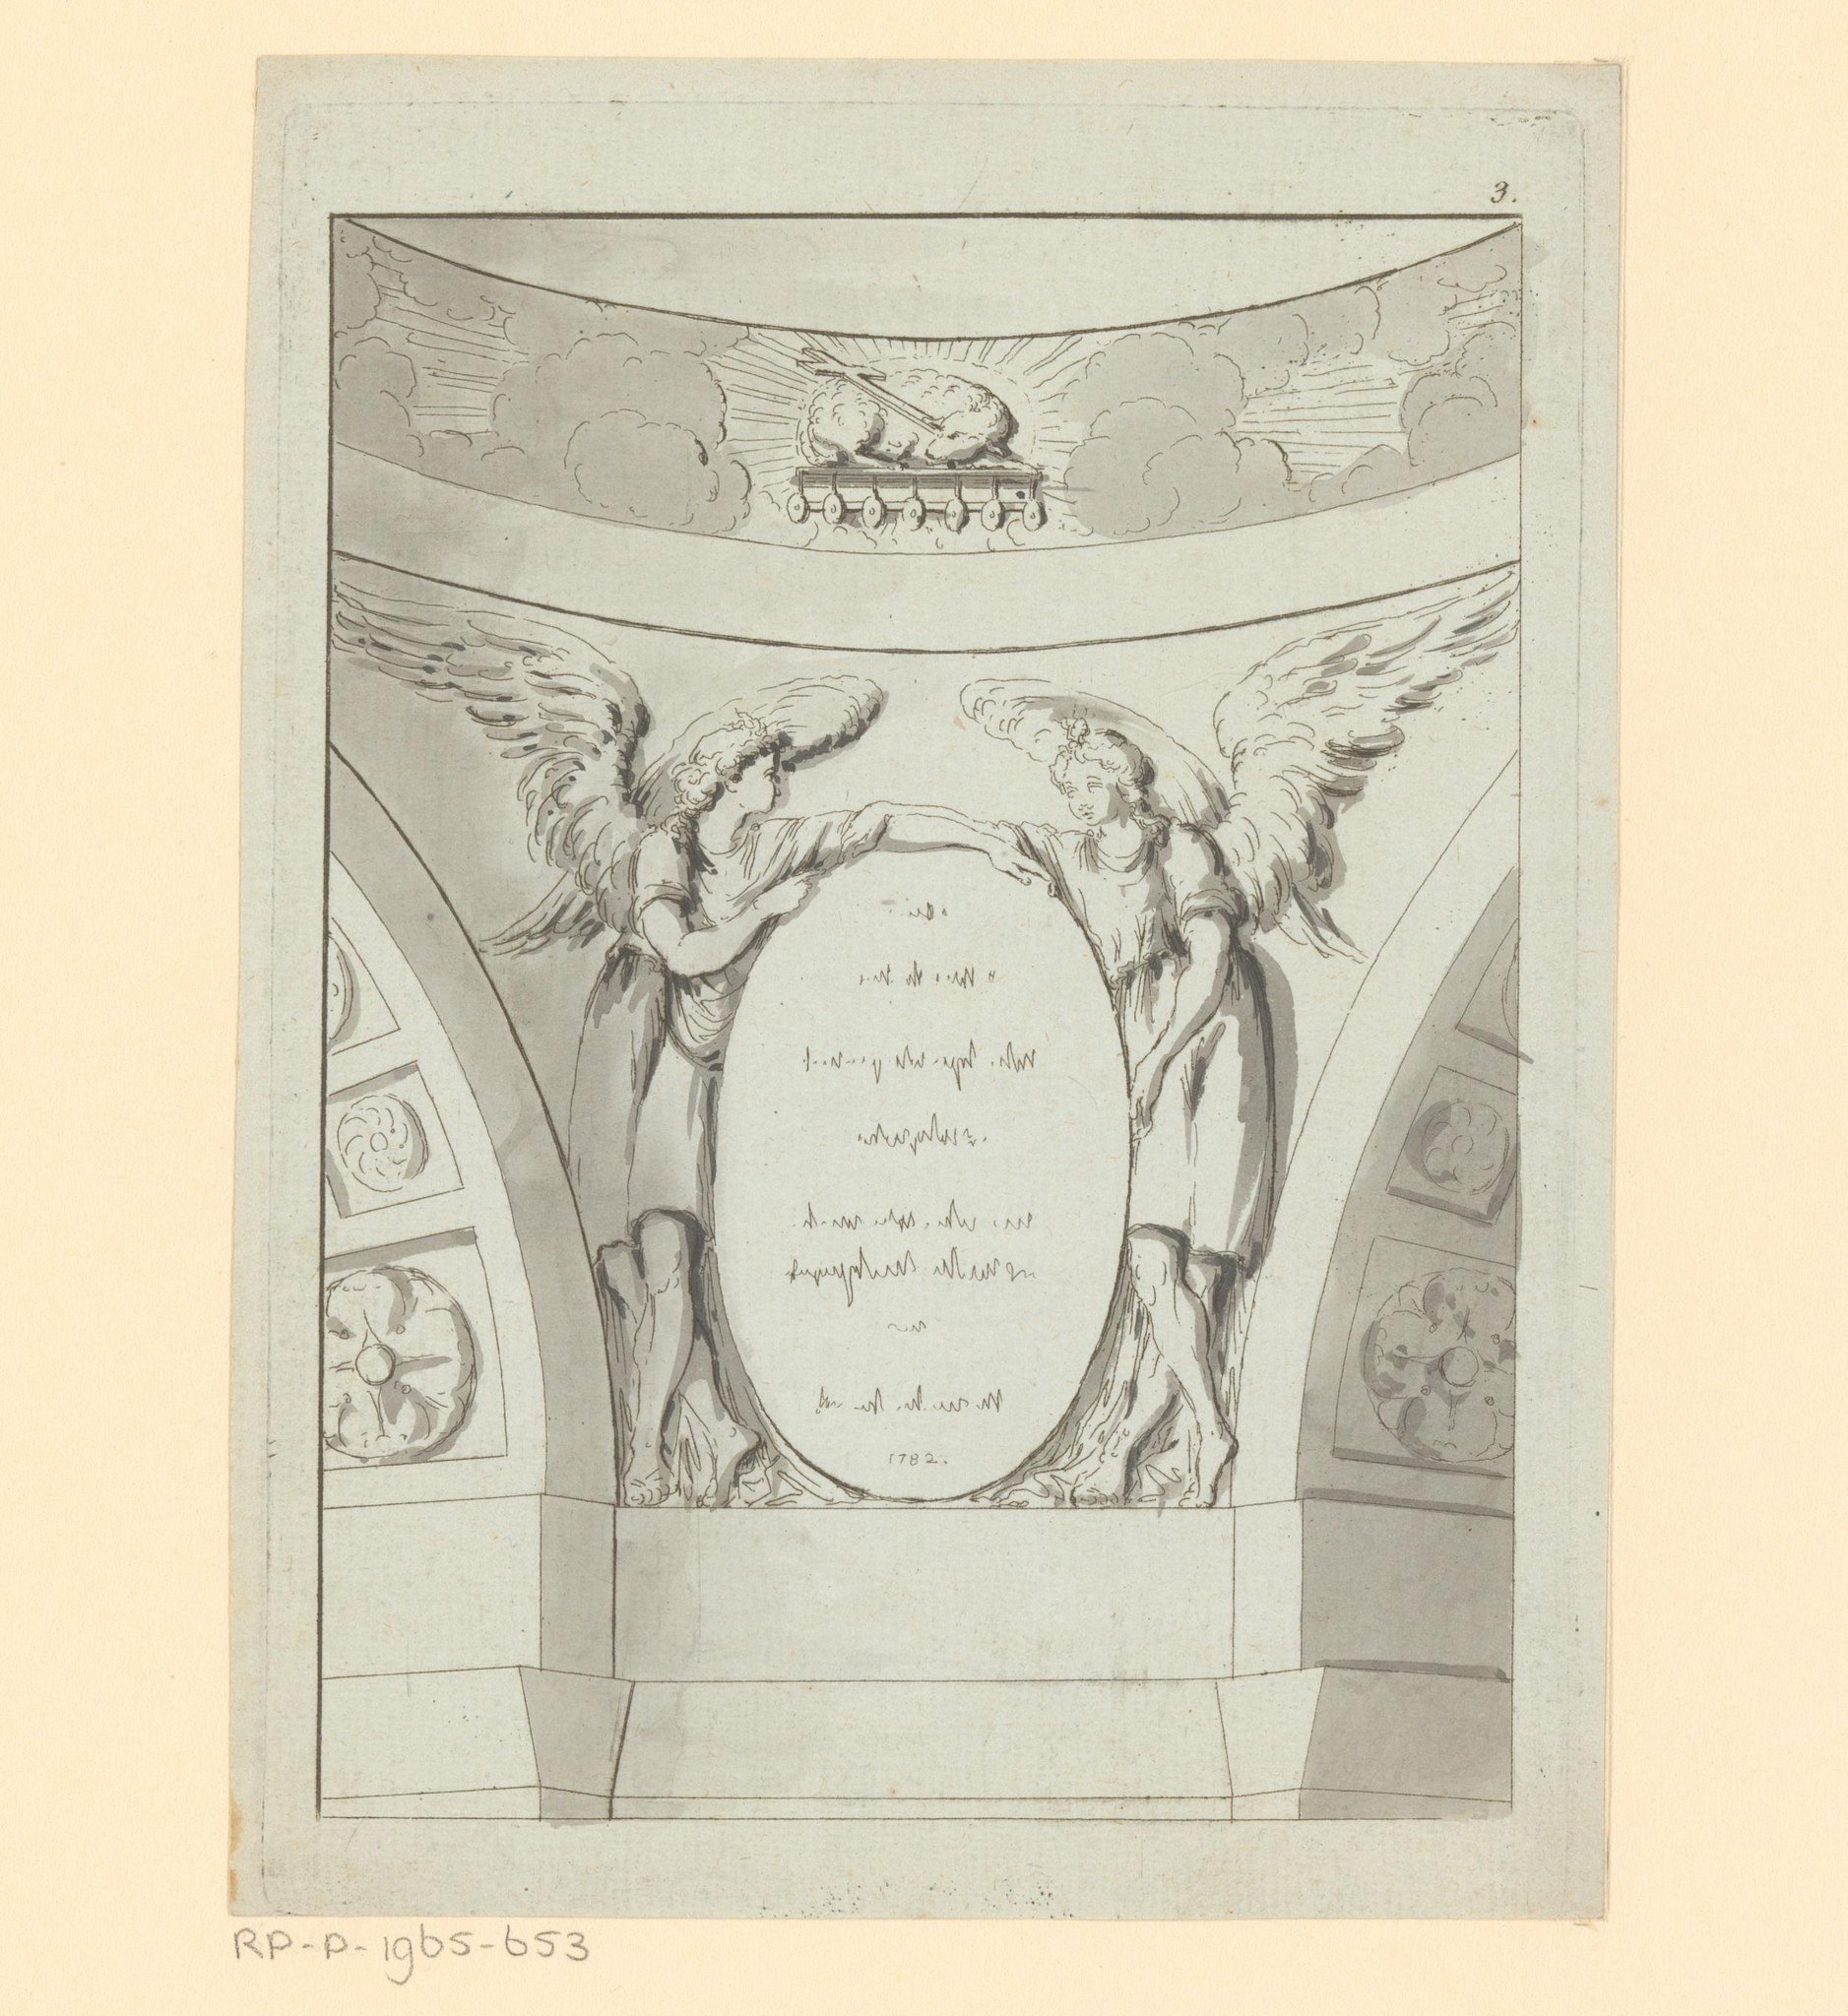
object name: print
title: Pendentief met engelen met medaillon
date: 1782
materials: paper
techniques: aquatint, etching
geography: paris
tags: ornament ~ medallion, dome ~ architecture, angels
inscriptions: collector's mark: Lugt 2228, collector's mark: Lugt 2760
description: Een pendentief met twee engelen met een ovaal medaillon. Aan de bovenzijde het lam op het boek met de zeven zegels.